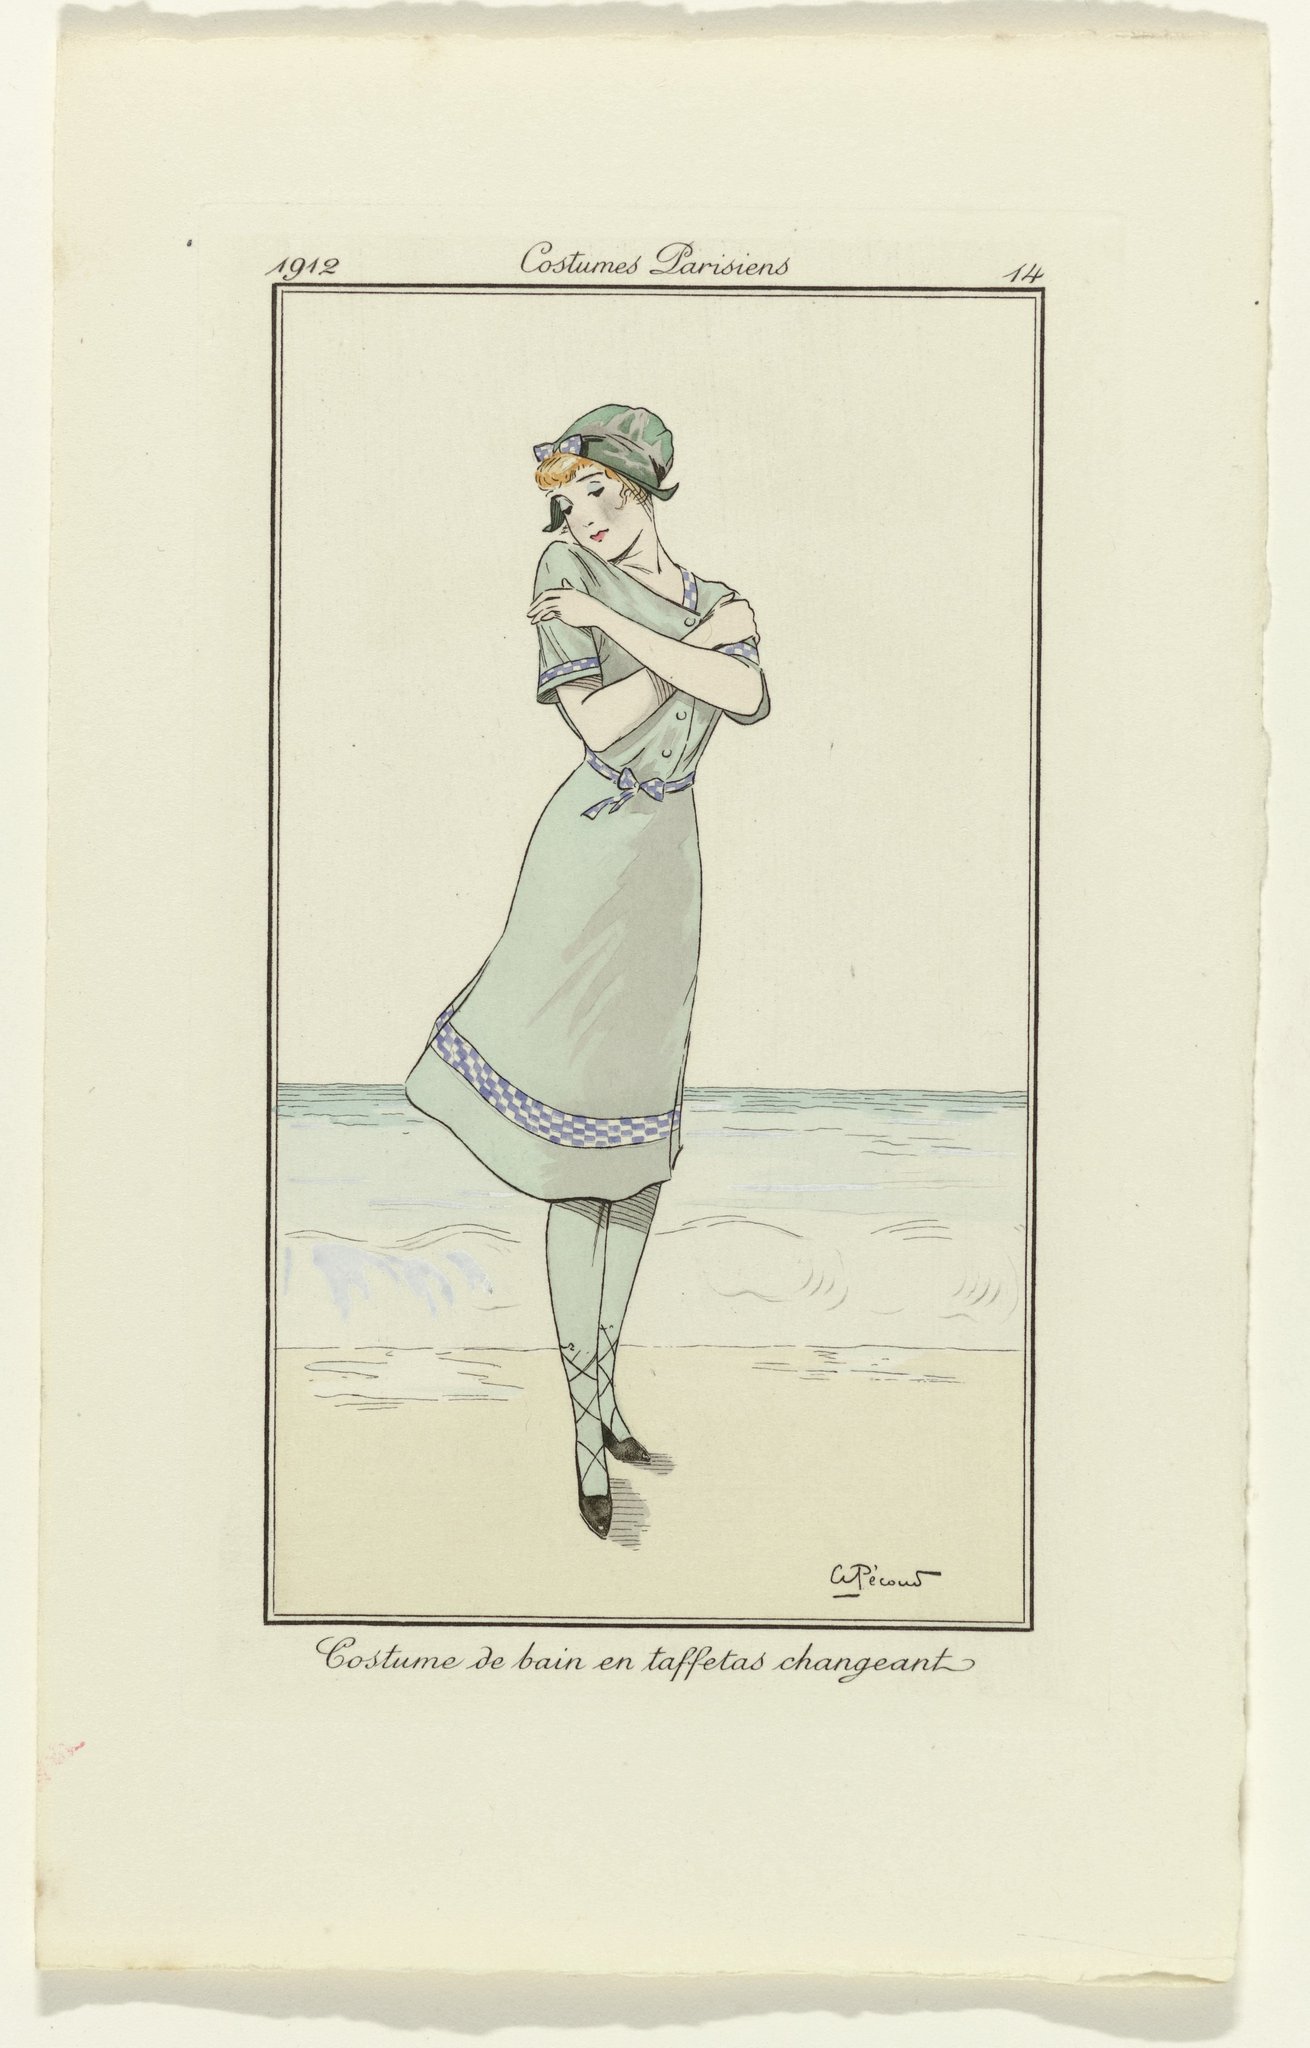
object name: fashion print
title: Journal des Dames et des Modes, 1912, Costumes Parisiens, no. 14: Costume de bain (...)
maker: Anonymous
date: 1912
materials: paper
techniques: engraving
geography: paris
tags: fashion plates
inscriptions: caption: ‘Costume de bain...’